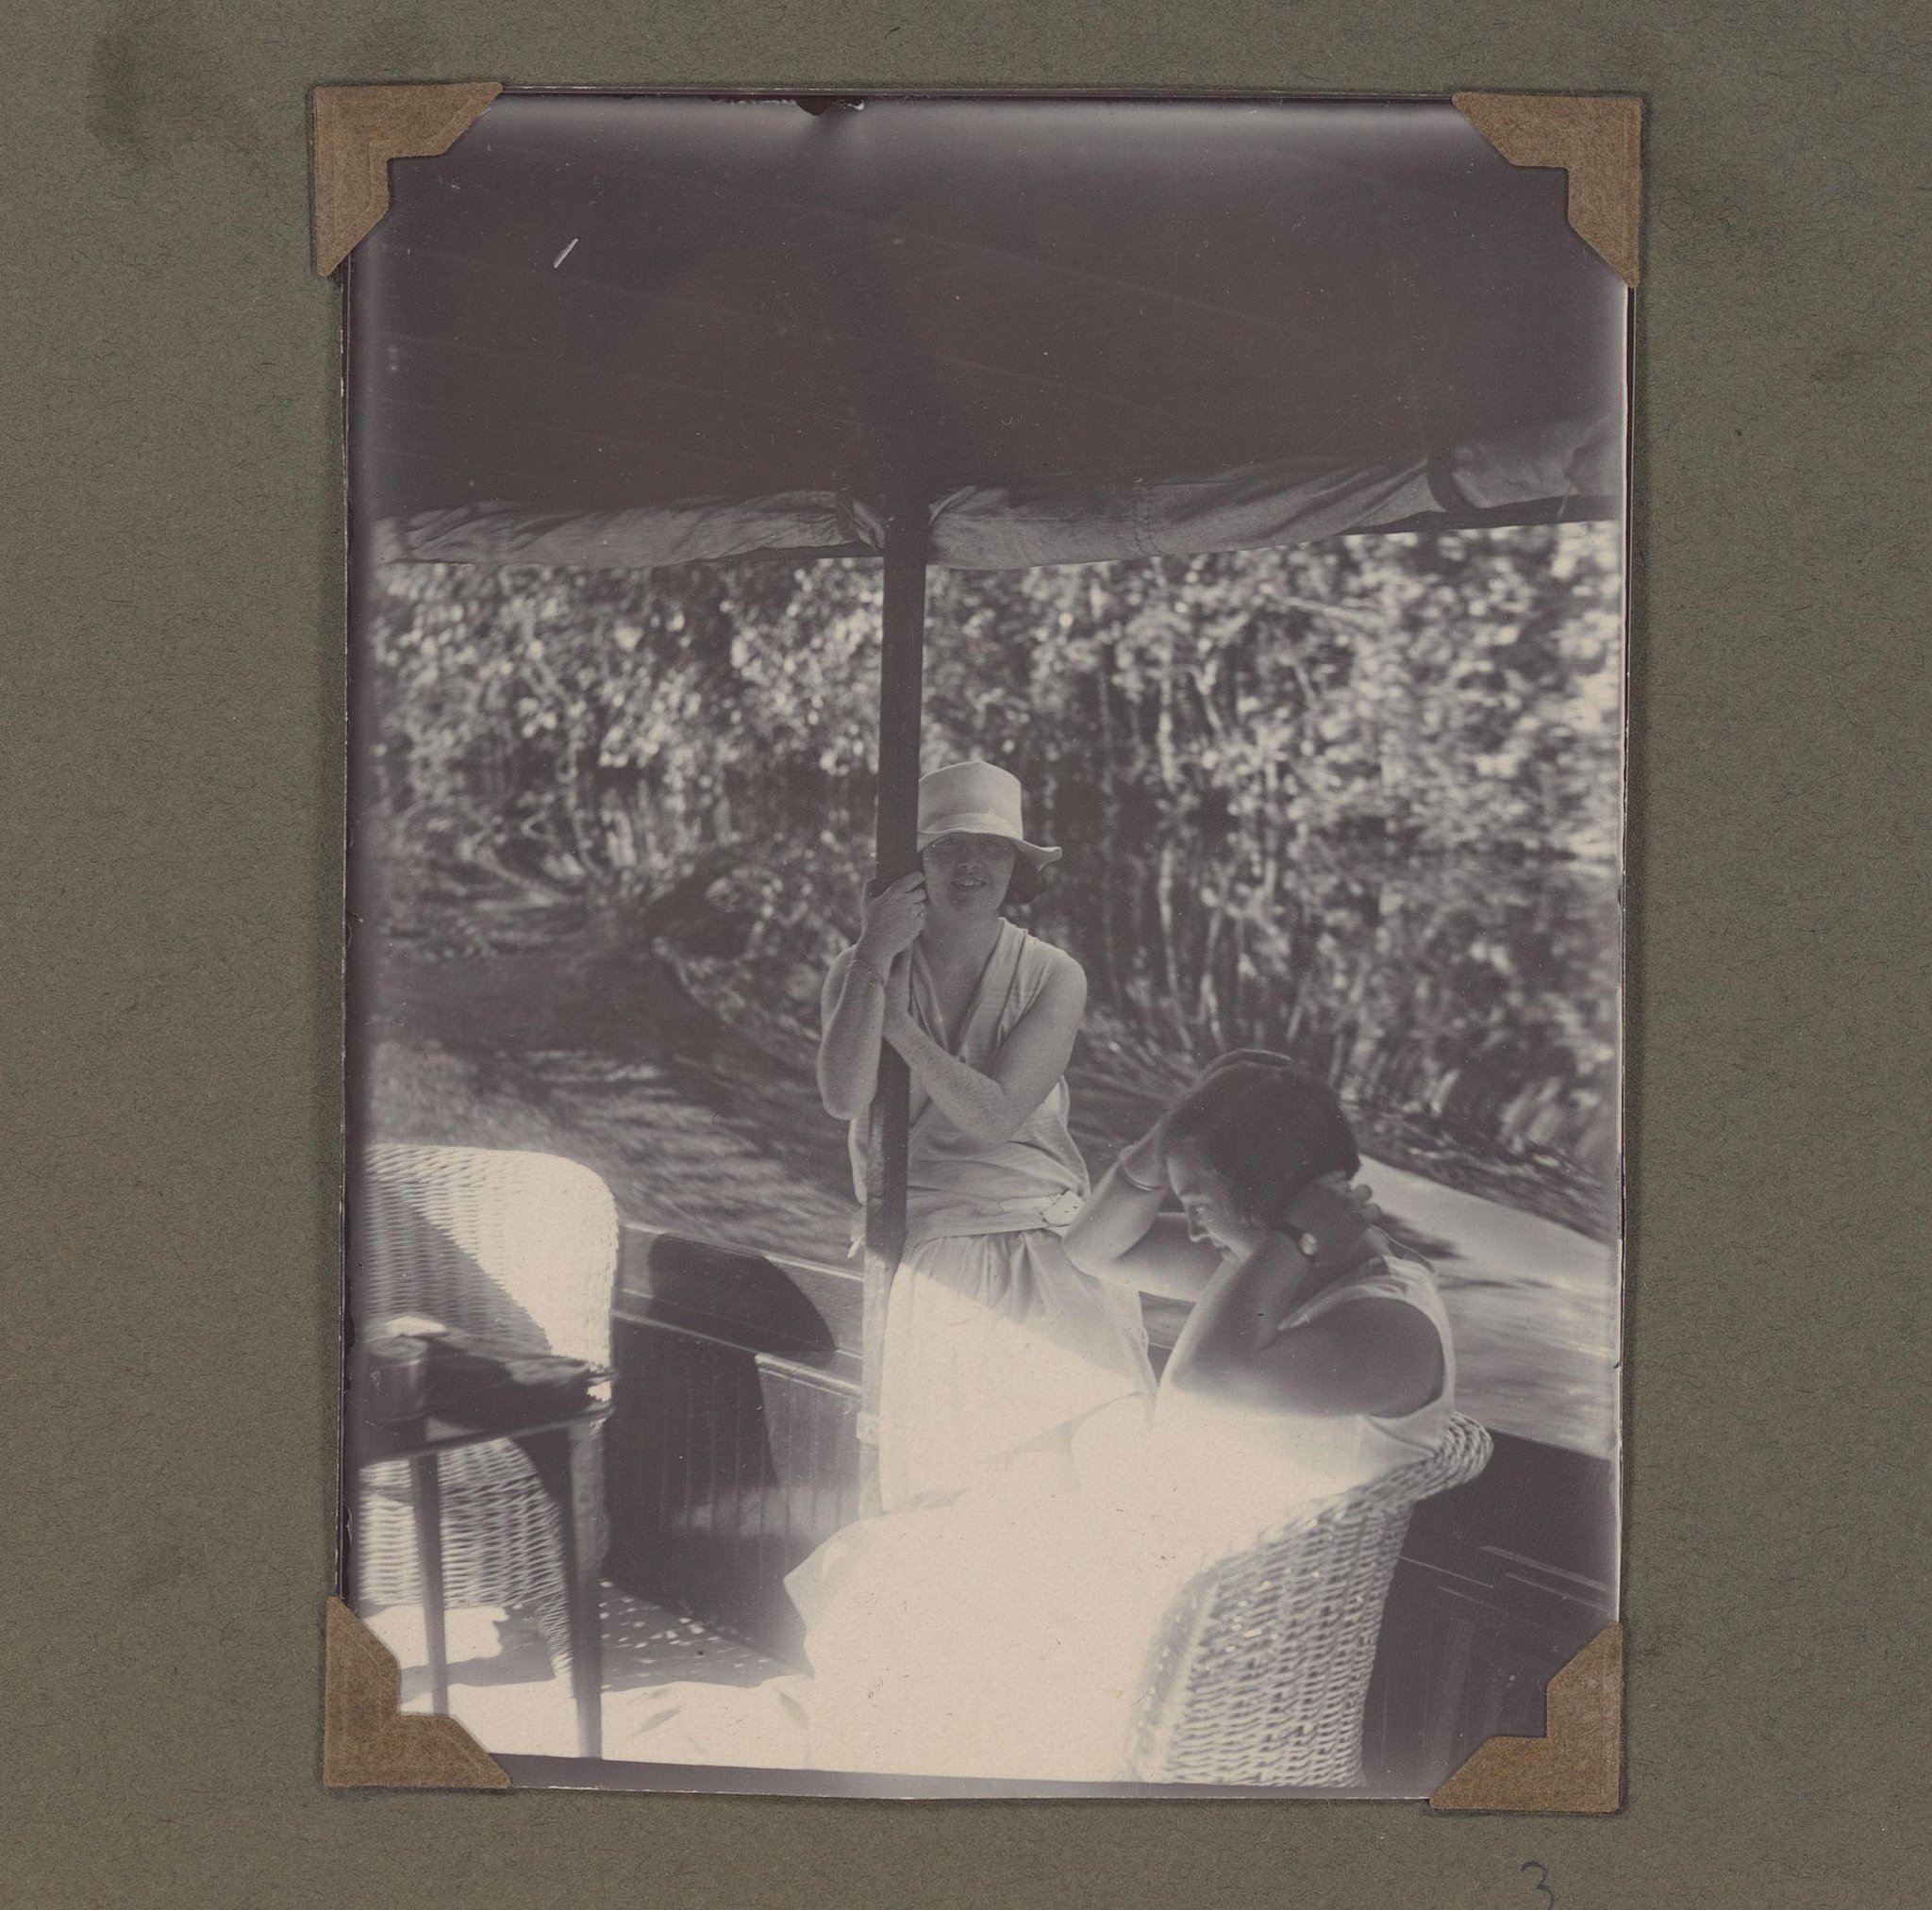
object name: photograph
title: Edith Jetten en een vrouw op een rivierboot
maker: Anonymous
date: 1925-1927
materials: photographic support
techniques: photography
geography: suriname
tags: jetten, familie, moengo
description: Edith Jetten en een andere vrouw op een rivierboot. Foto op een bladzijde van een los albumblad. Onderdeel van het ensemble met foto's van de familie van ingenieur Jetten in de mijnbouwstad Moengo in Suriname.